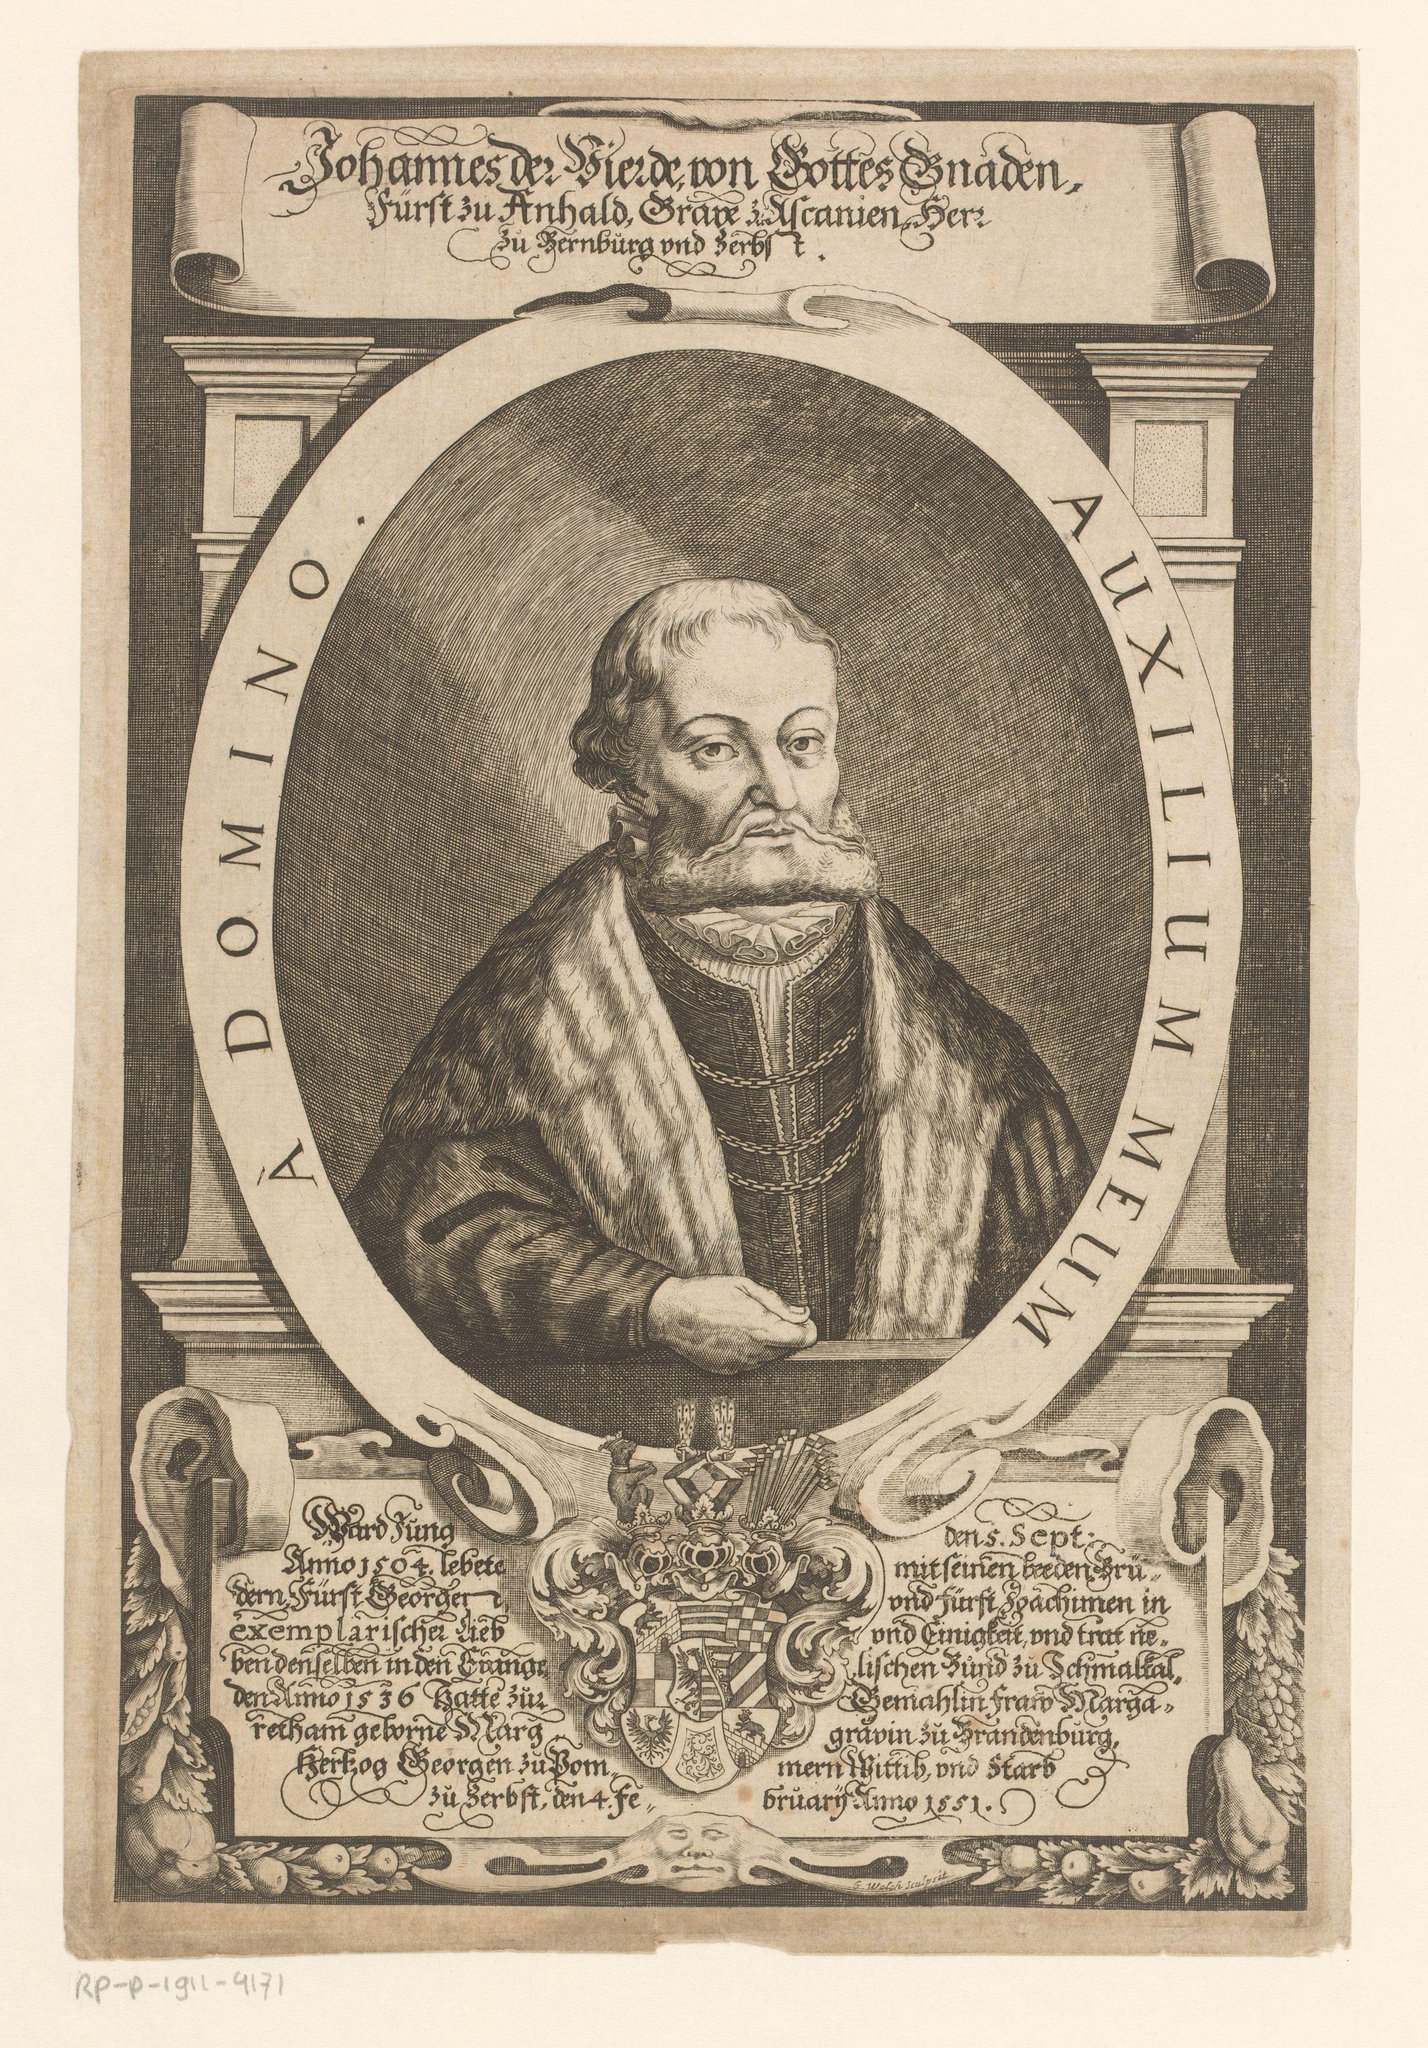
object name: print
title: Portret van Johan IV van Anhalt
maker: georg walch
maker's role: print maker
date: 1632-1654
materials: paper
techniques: engraving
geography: nuremberg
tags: coat of arms (symbol of sovereignty), historical persons, ruler, sovereign, beard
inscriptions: collector's mark: Lugt 2228